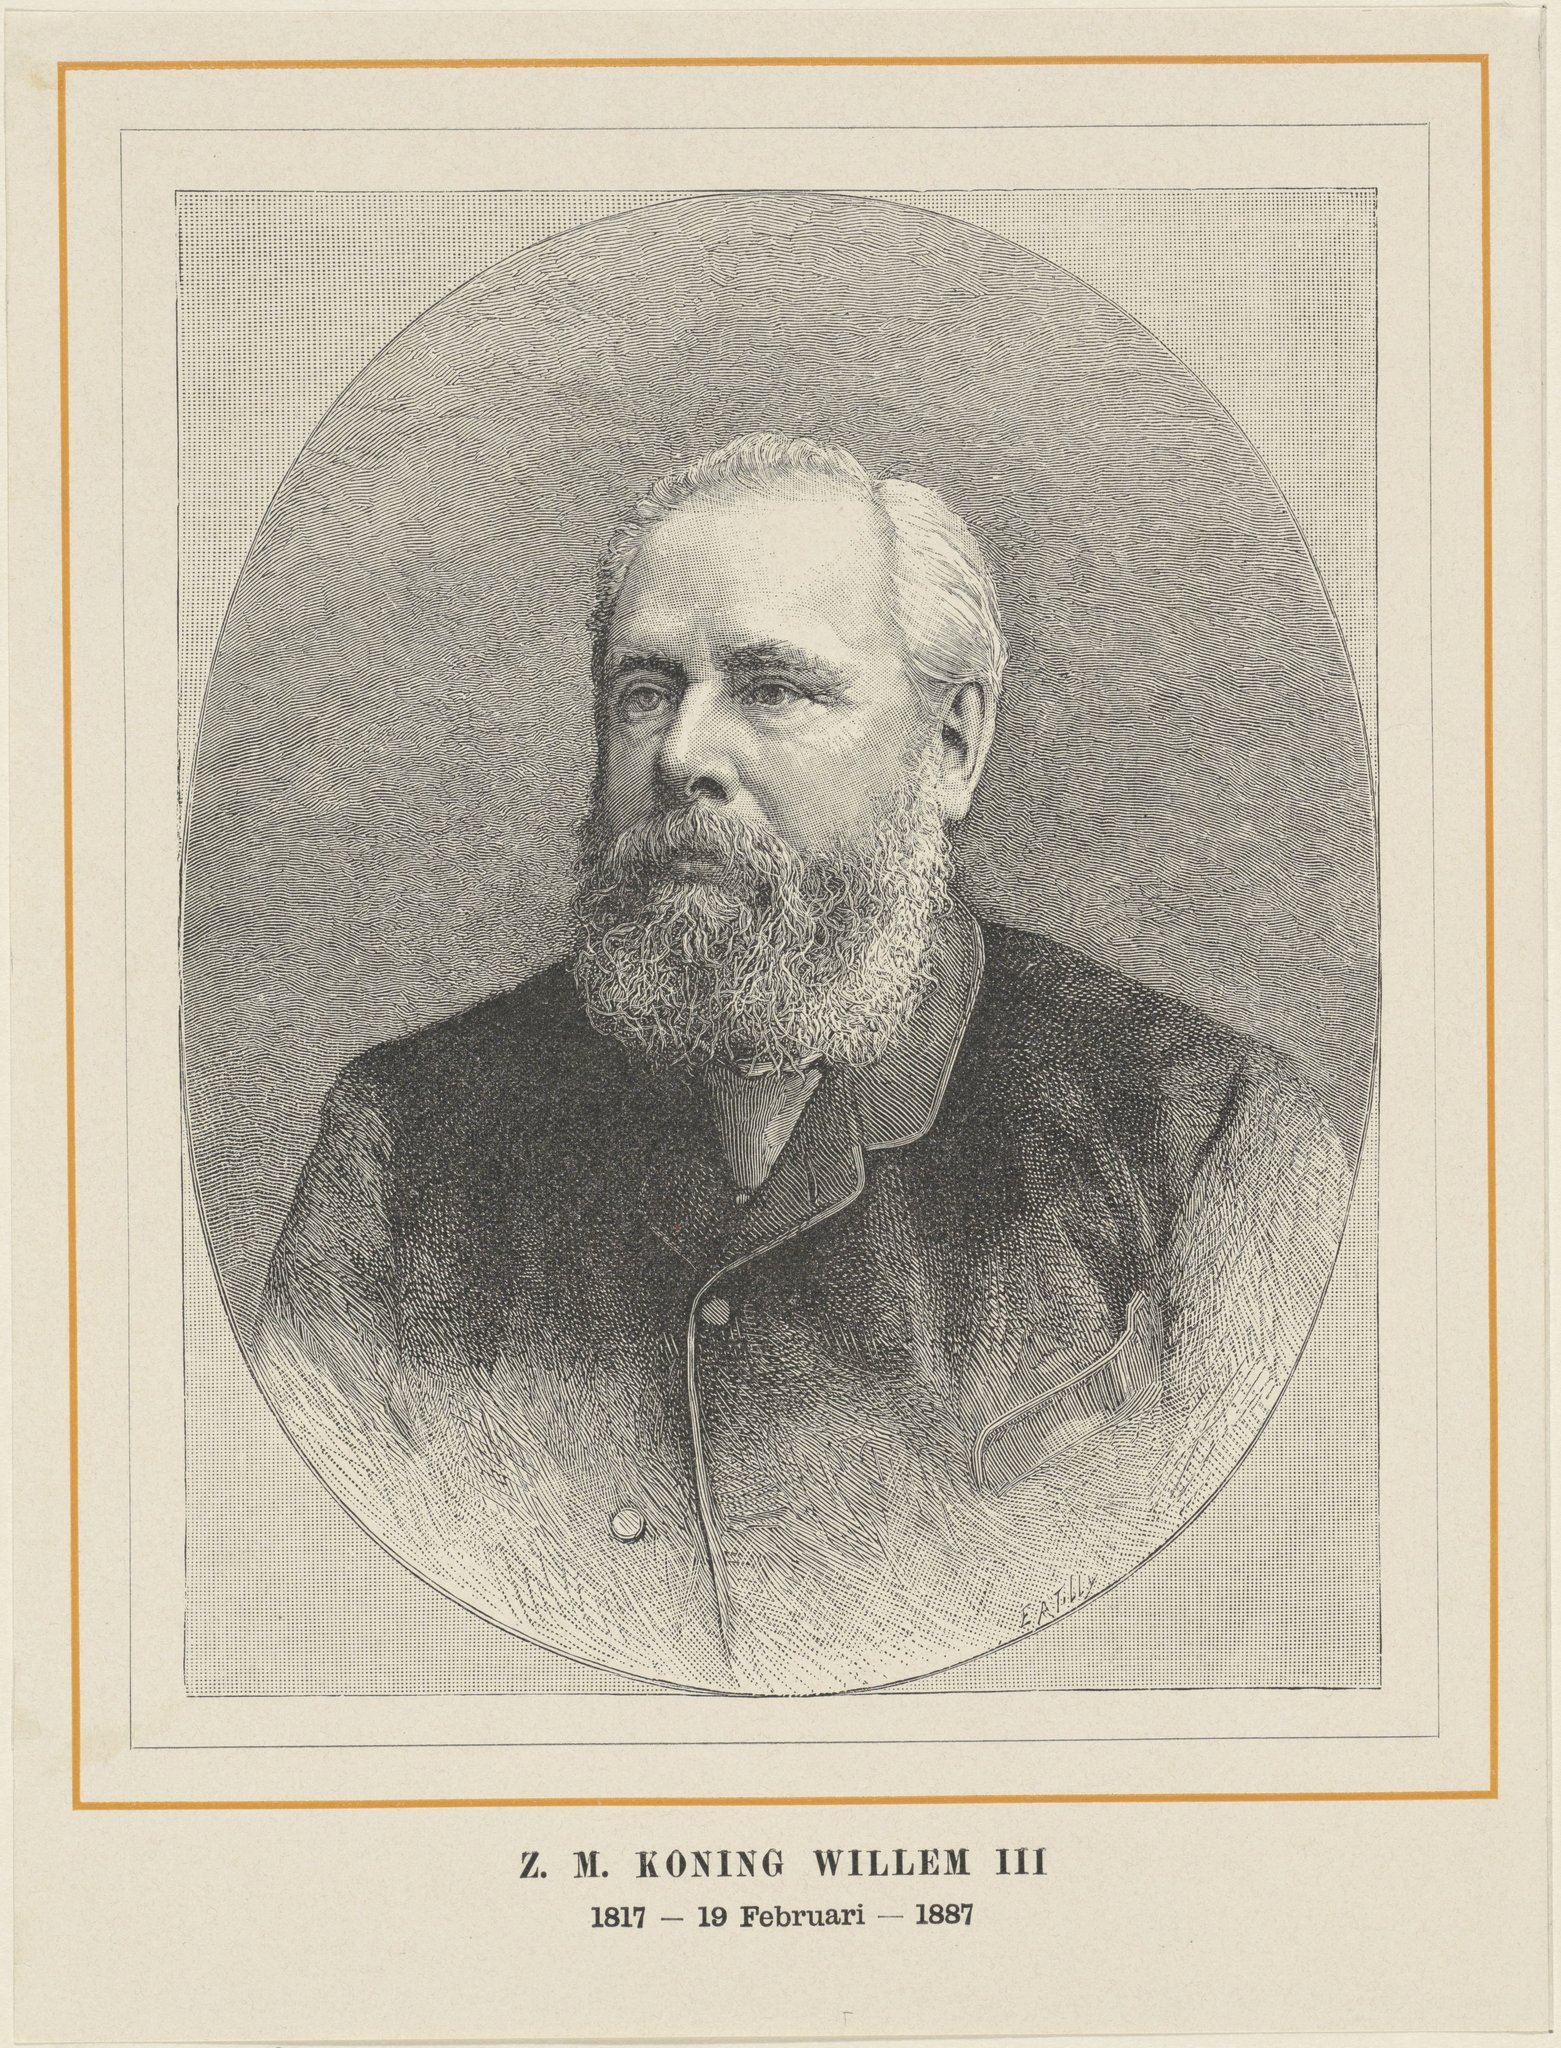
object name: print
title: Portret van Willem III, koning der Nederlanden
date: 1887-1889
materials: paper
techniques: letterpress printing, engraving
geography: amsterdam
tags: brussels, willem iii (koning der nederlanden)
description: Portret van Willem III in een ovaal. In de ondermarge twee regels Nederlandse tekst in boekdruk. Vervaardigd ter gelegenheid van de viering van de zeventigste verjaardag van Willem III op 19 februari 1887.